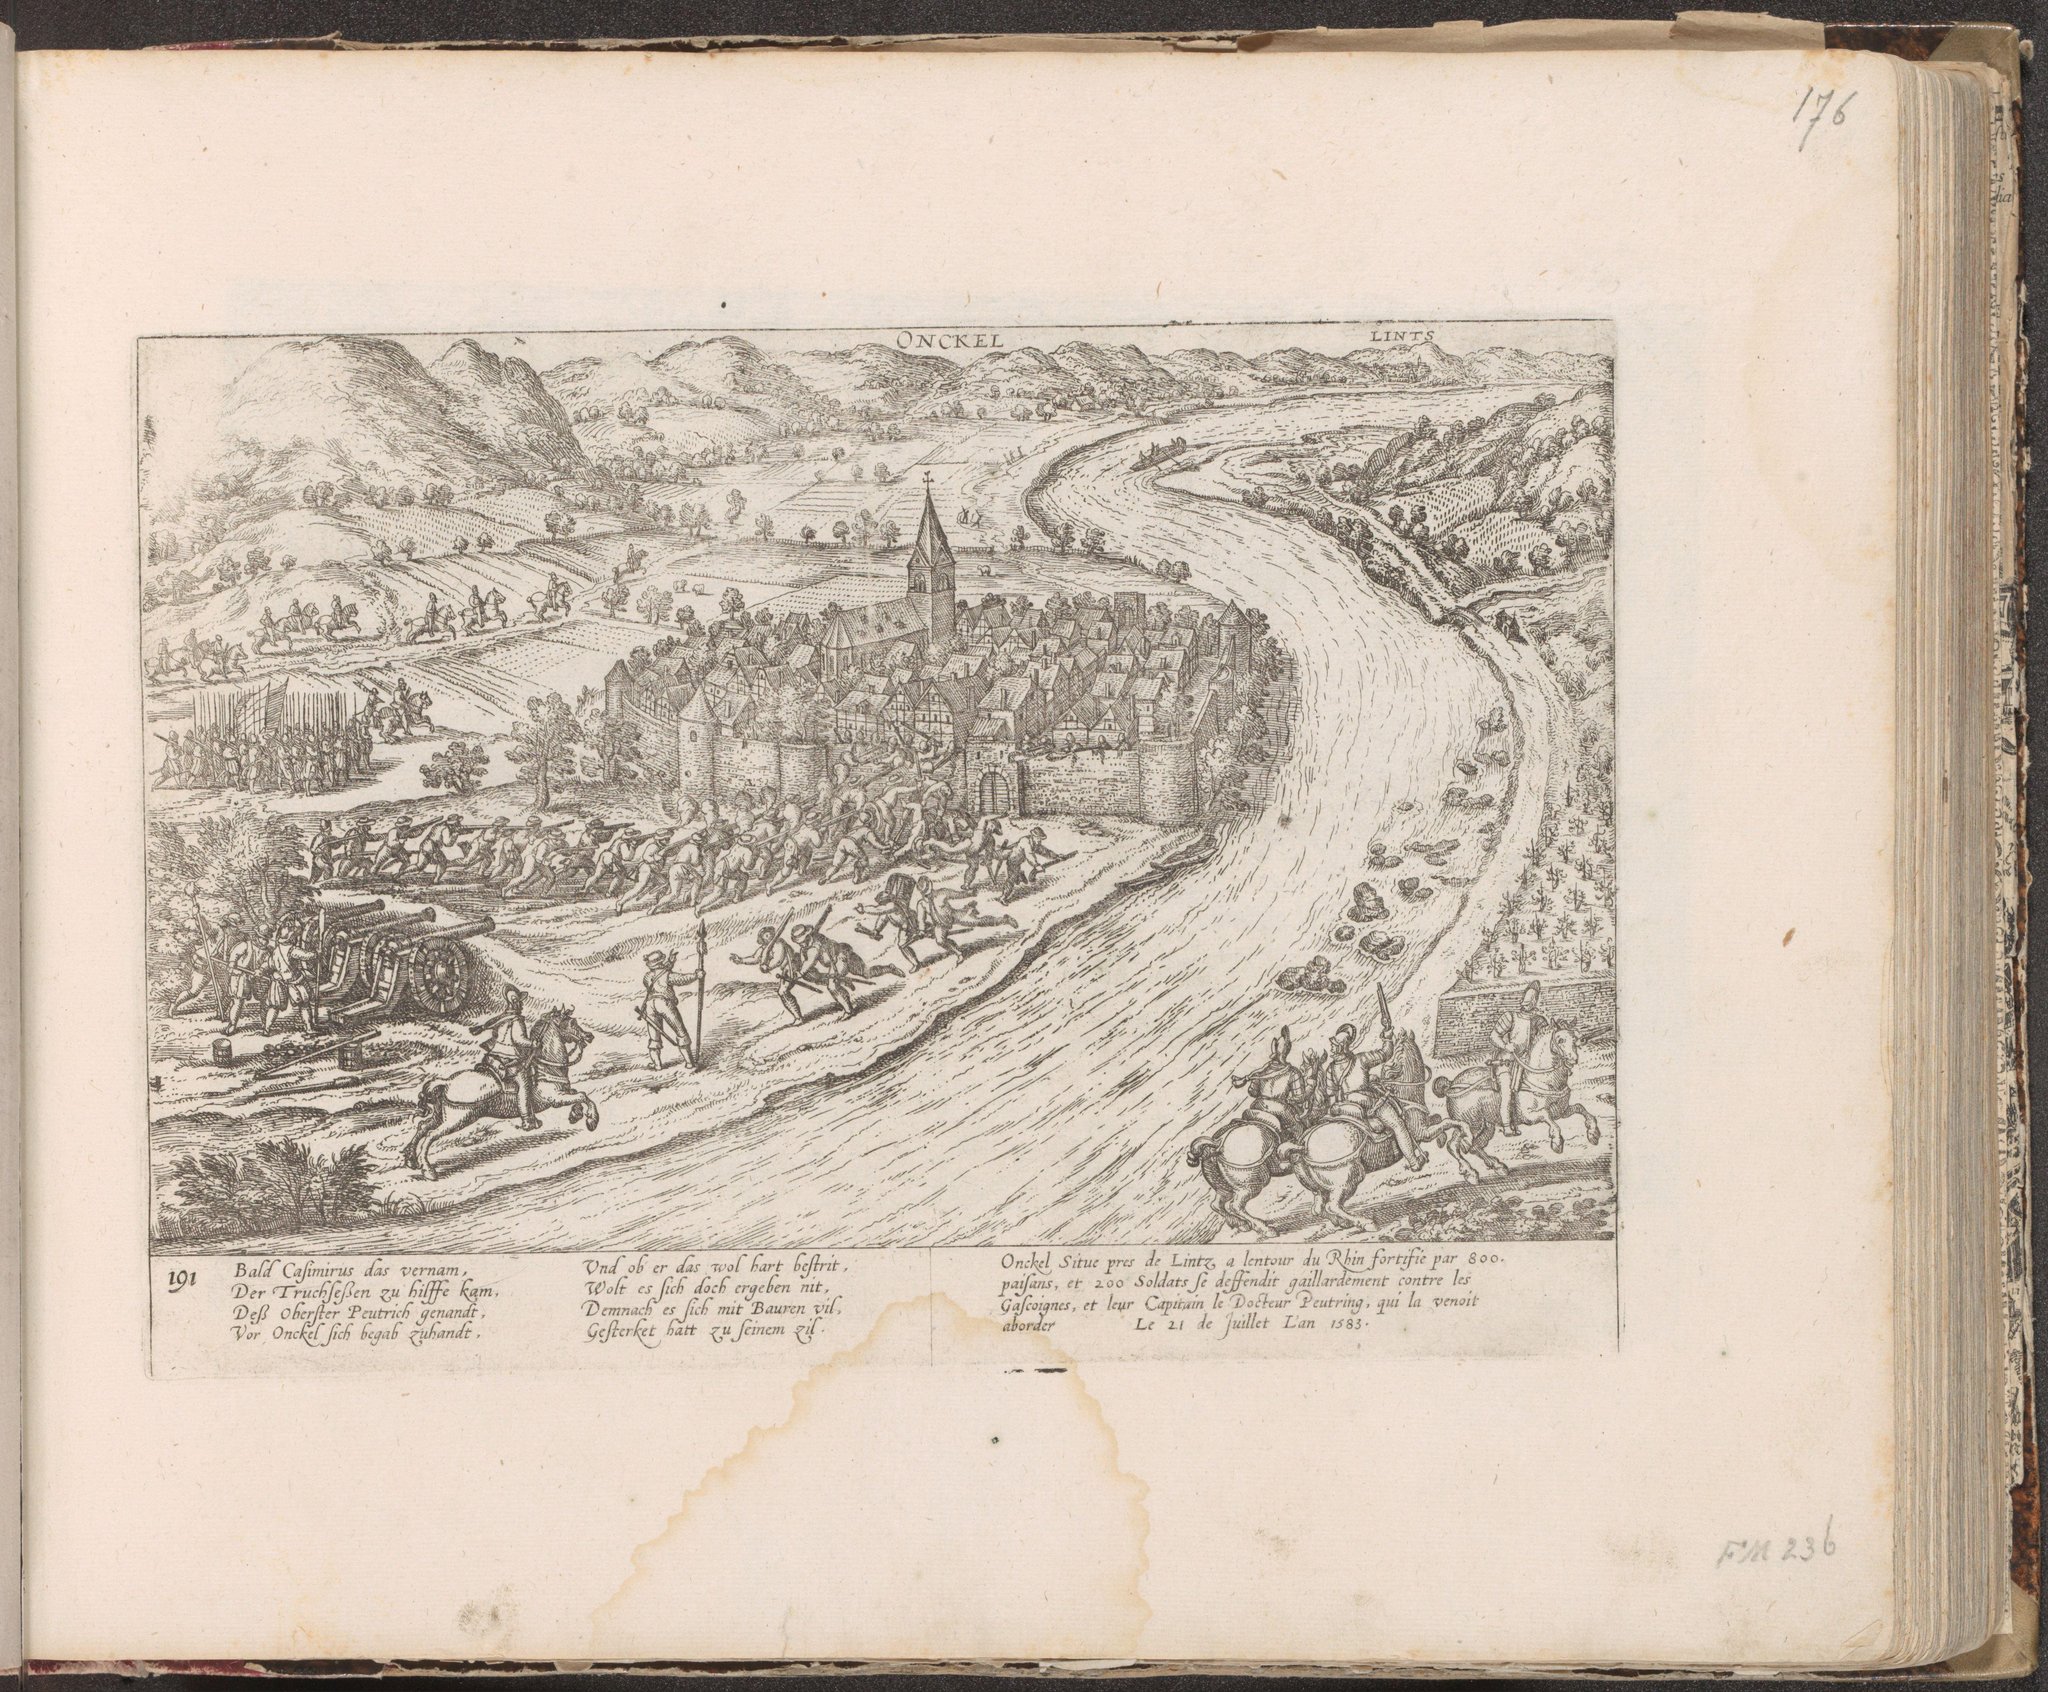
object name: album leaf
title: Unkel aangevallen, 1583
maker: frans hogenberg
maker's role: print maker, publisher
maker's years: 1538-1590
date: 1587-1591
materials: paper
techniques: etching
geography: cologne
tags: siege, position war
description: Aanval op de stad Unkel aan de Rijn, 21 juli 1583. Episode uit de Keulse Oorlog. Met onderschrift van 8 regels in het Duits en 4 regels in het Frans. Linksonder genummerd: 191. De prent maakt deel uit van een album.